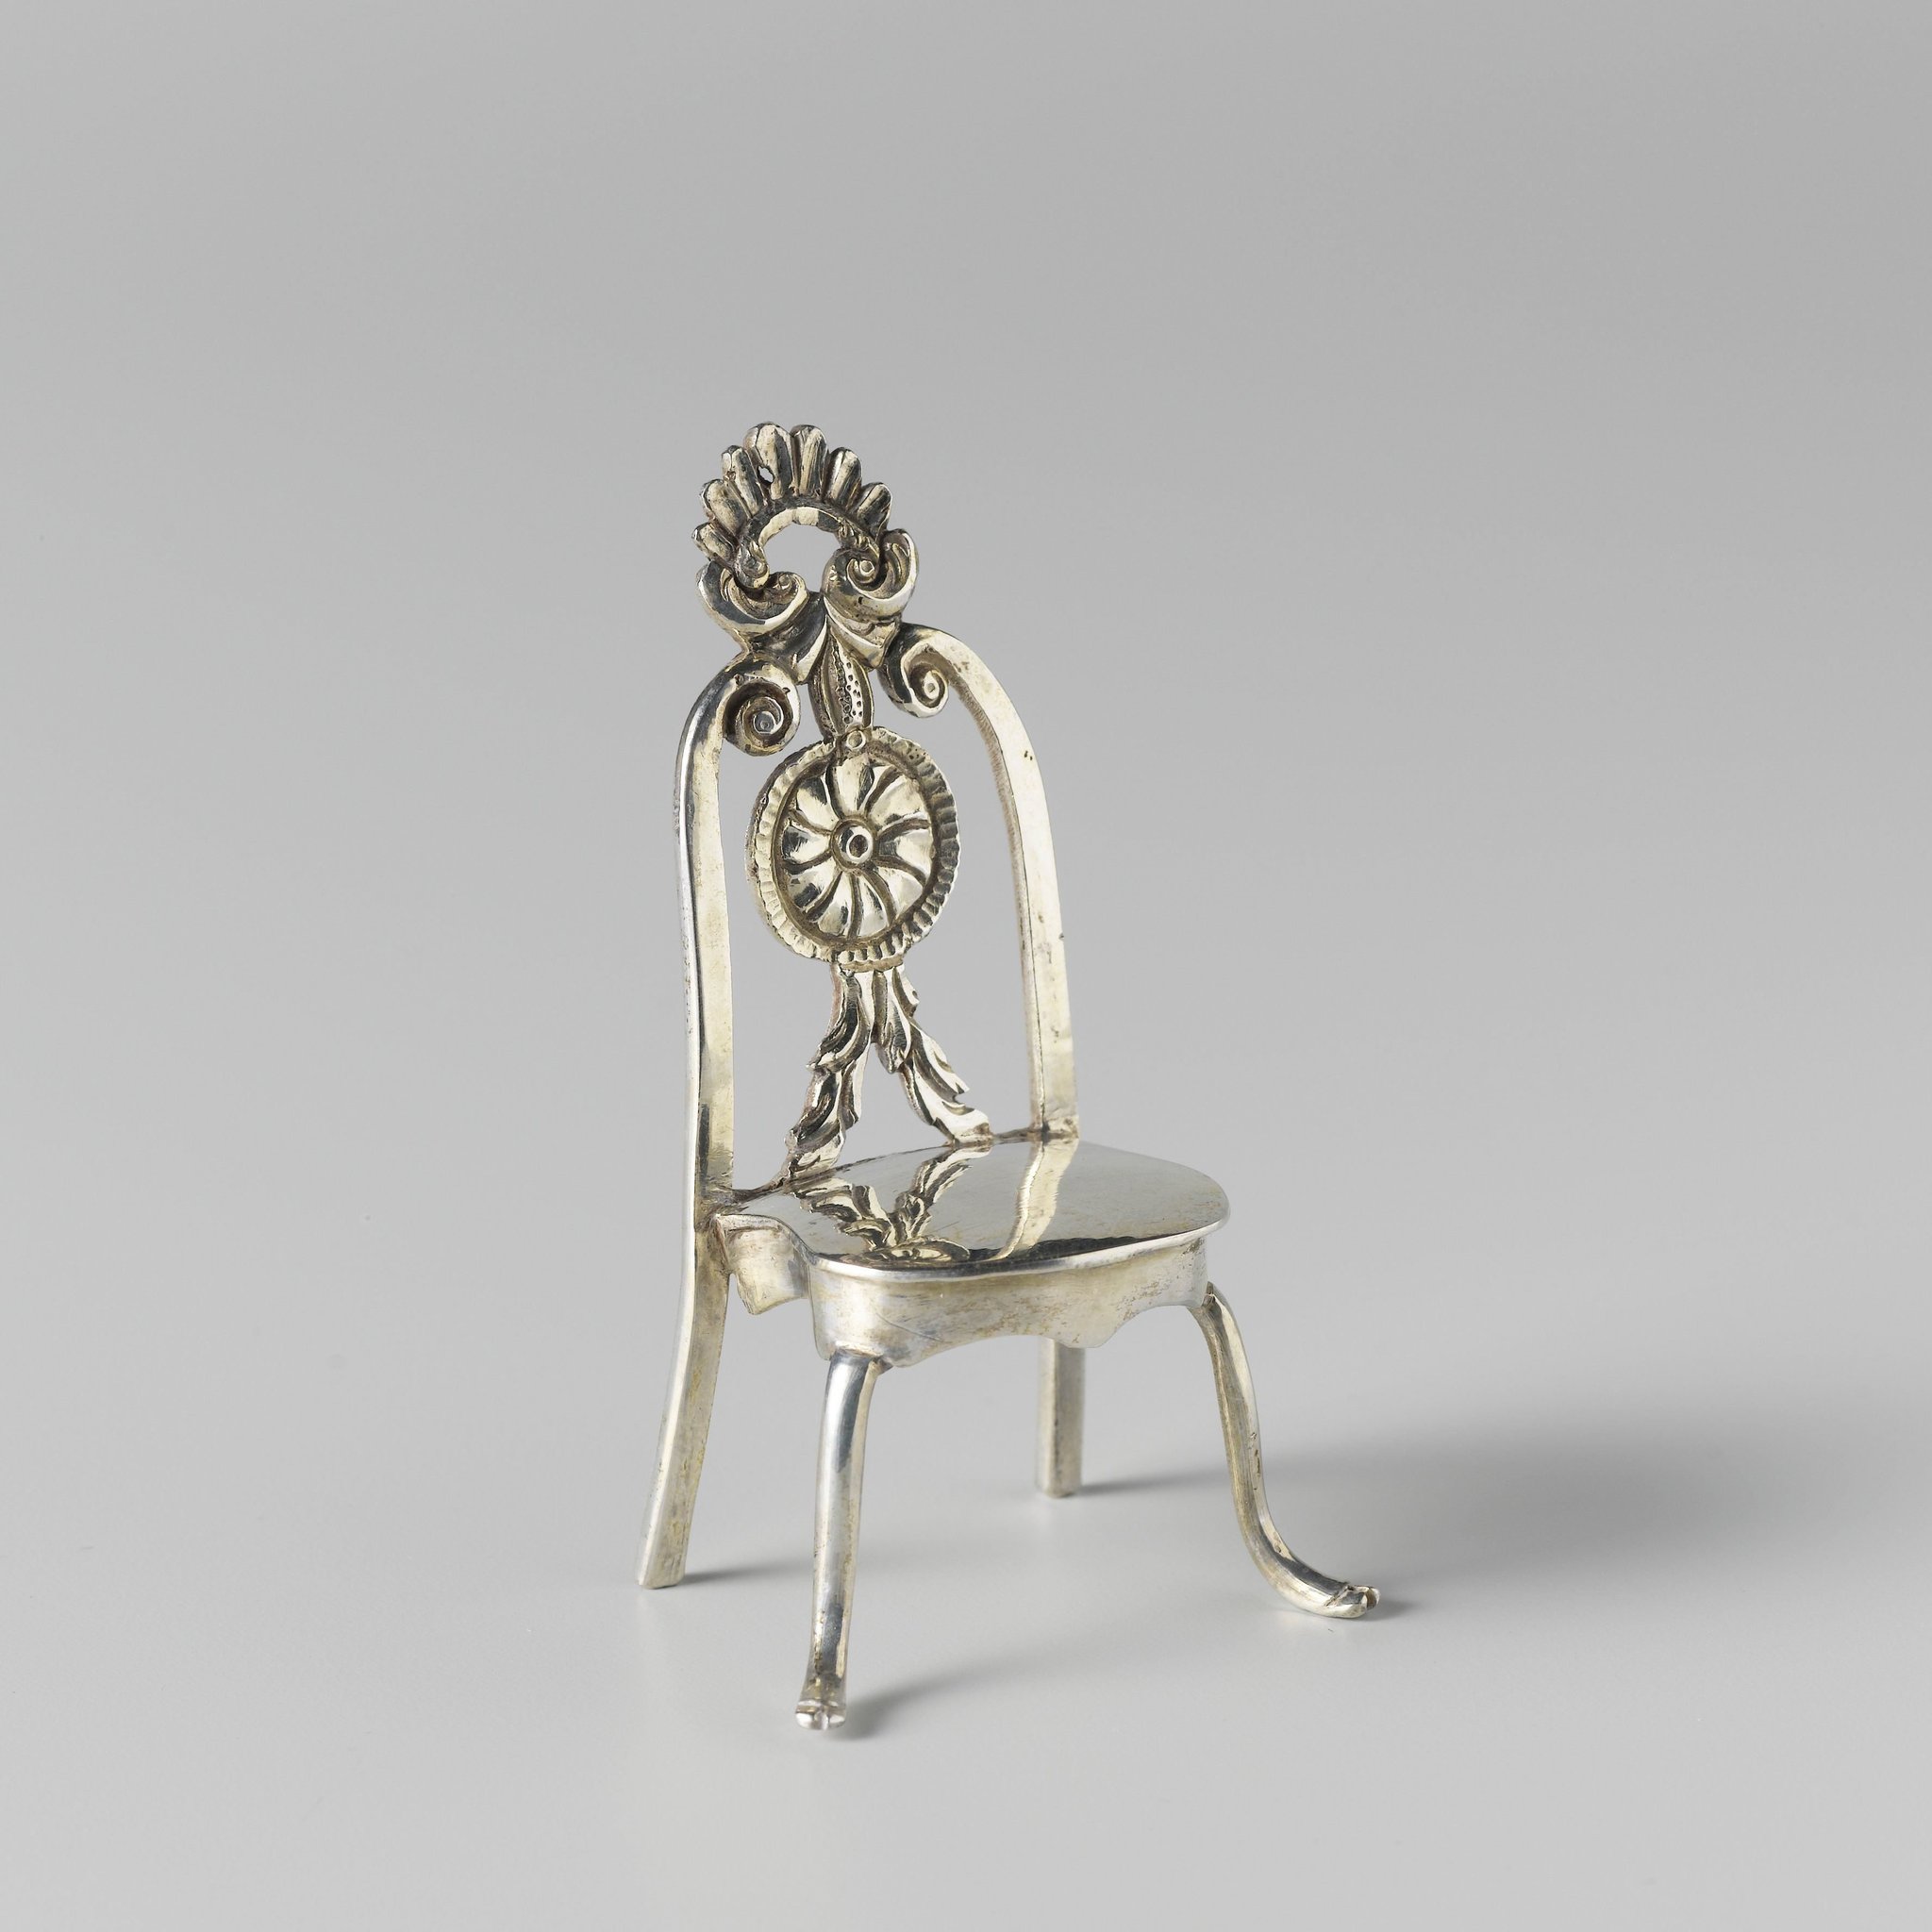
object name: miniature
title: Stoel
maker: jan bonket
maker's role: silversmith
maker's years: 1727-1789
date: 1779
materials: silver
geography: amsterdam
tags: chair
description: Stoel met gladde, kolfvormige zitting en voluutvormige voorpoten. De opengewerkte rugleuning wordt bekroond door een kuif. Het midden van de rugleuning wordt gevormd door een rozet en bladslingers. De stoel is gemerkt: stk.= Amsterdam, jrl.= 1779, mt.= Jan Bonket. De stoel hoort bij vijf identieke exemplaren (BK-NM-11177-169, BK-NM-11177-170, BK-NM-11177-171, BK-NM-11177-173 en BK-NM-11177-174).